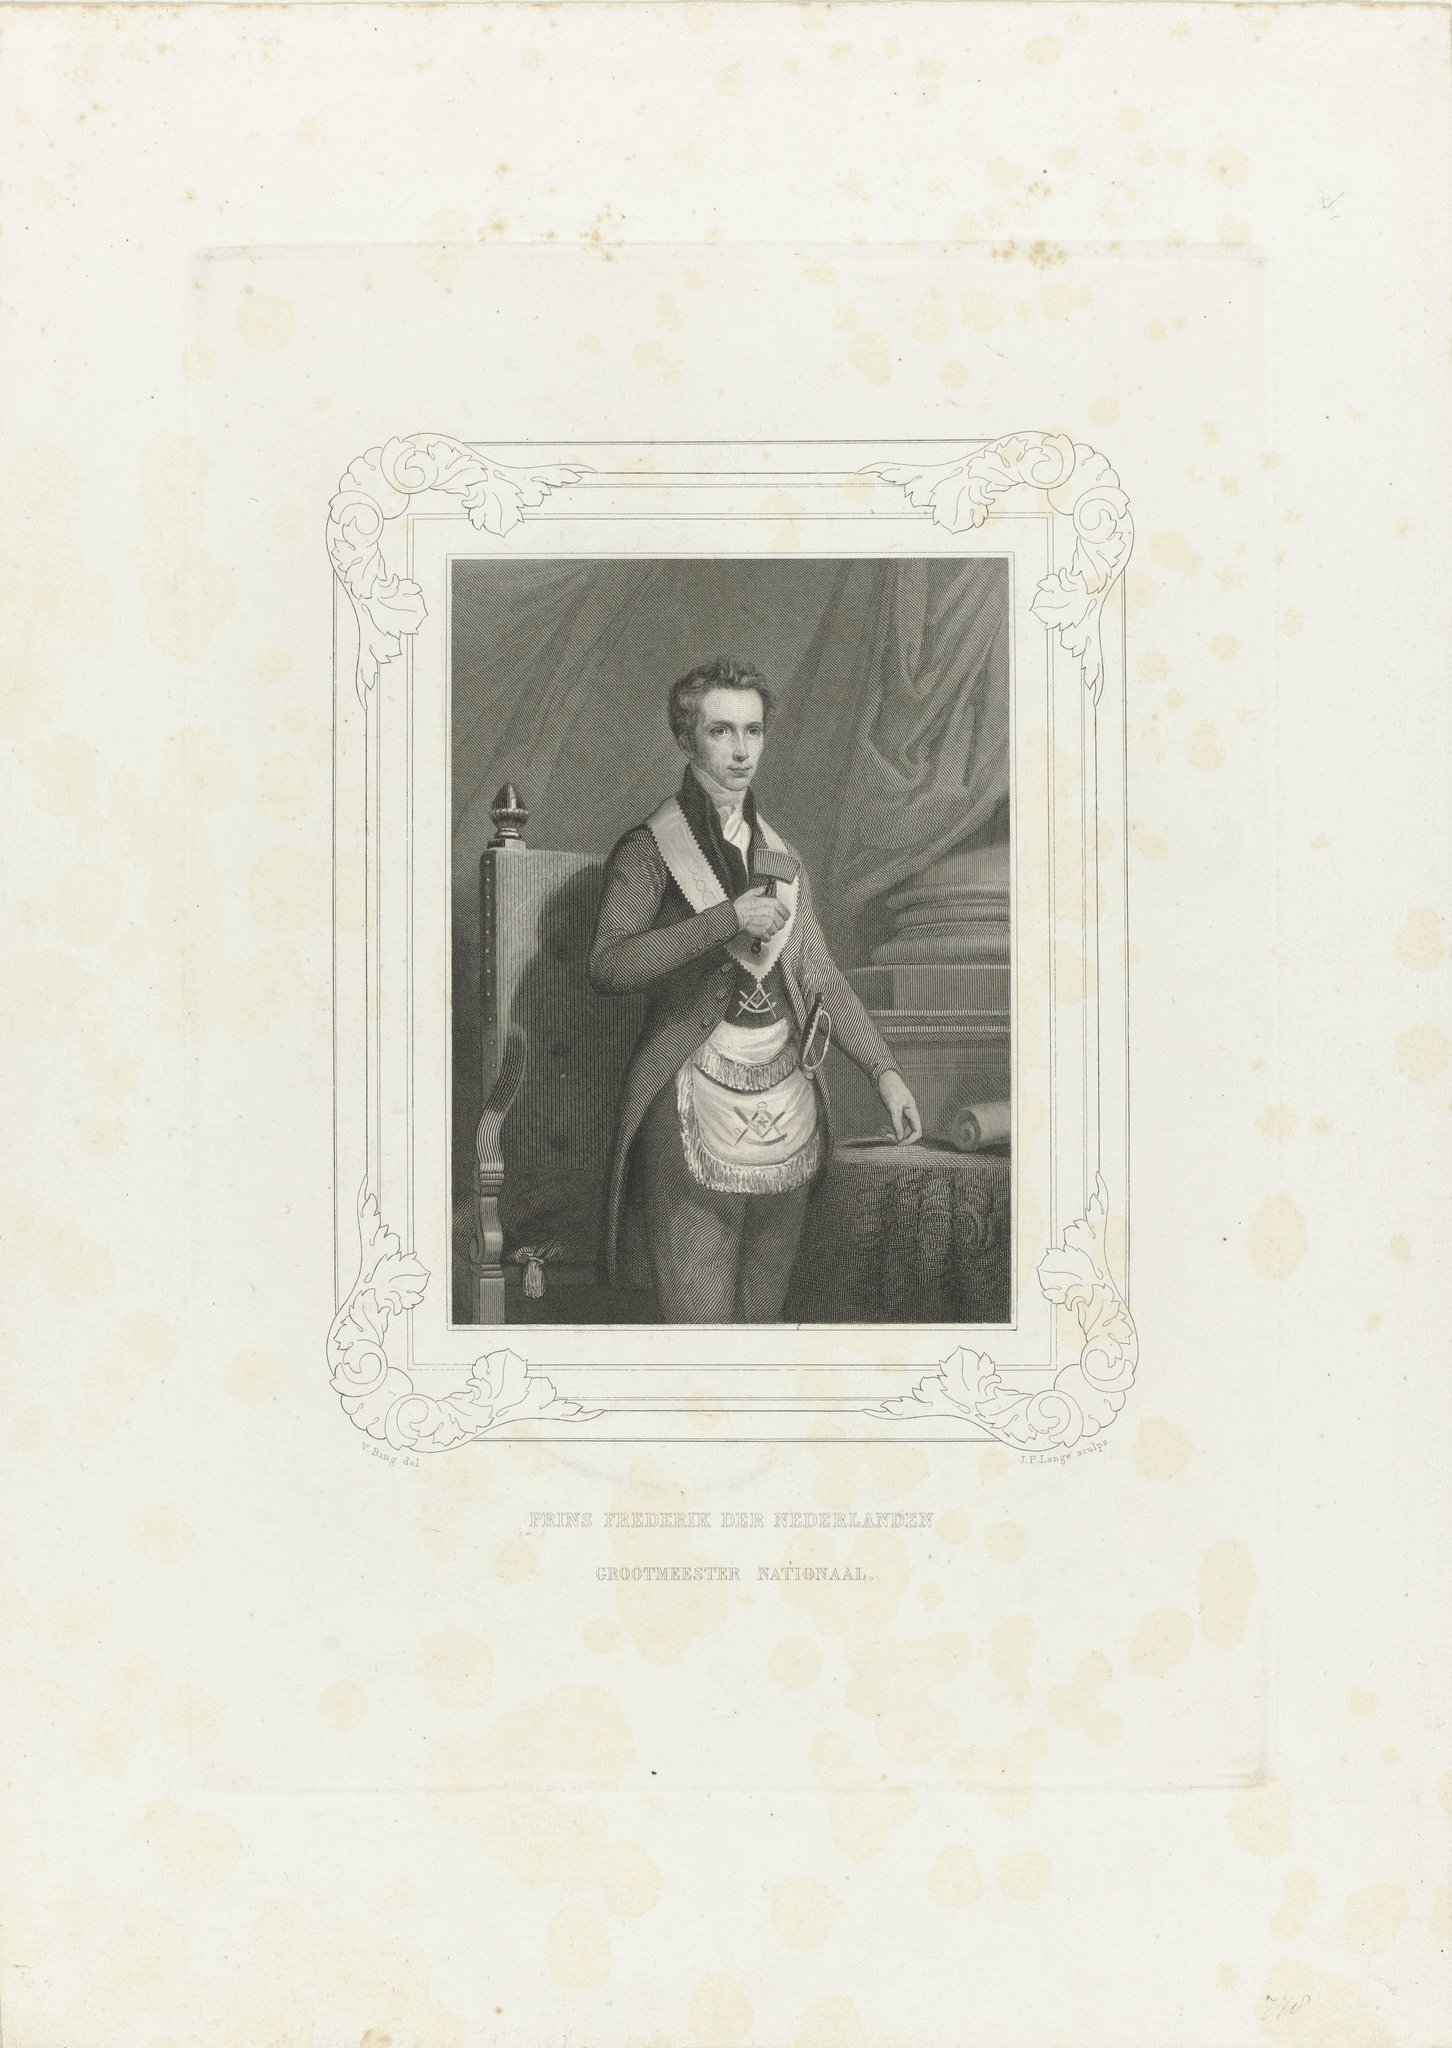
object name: print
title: Portret van Frederik, prins der Nederlanden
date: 1825-1849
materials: paper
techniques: engraving, etching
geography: amsterdam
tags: berlin, frederik (prins der nederlanden)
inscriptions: collector's mark: Lugt 963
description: Portret van Frederik als grootmeester der Vrijmetselaren in een geornamenteerde rechthoek. Hij staat naast een tafel met daarop een rol. In zijn rechterhand een hamer. In de ondermarge zijn naam en titels. Losse bestellingslijst in boekdruk.